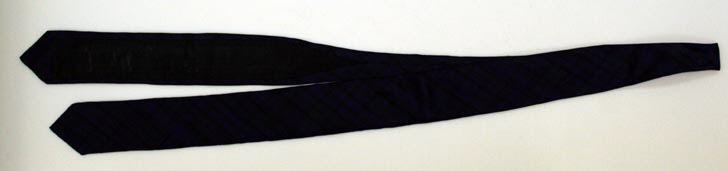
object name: necktie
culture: american or european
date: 1890-1899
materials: silk